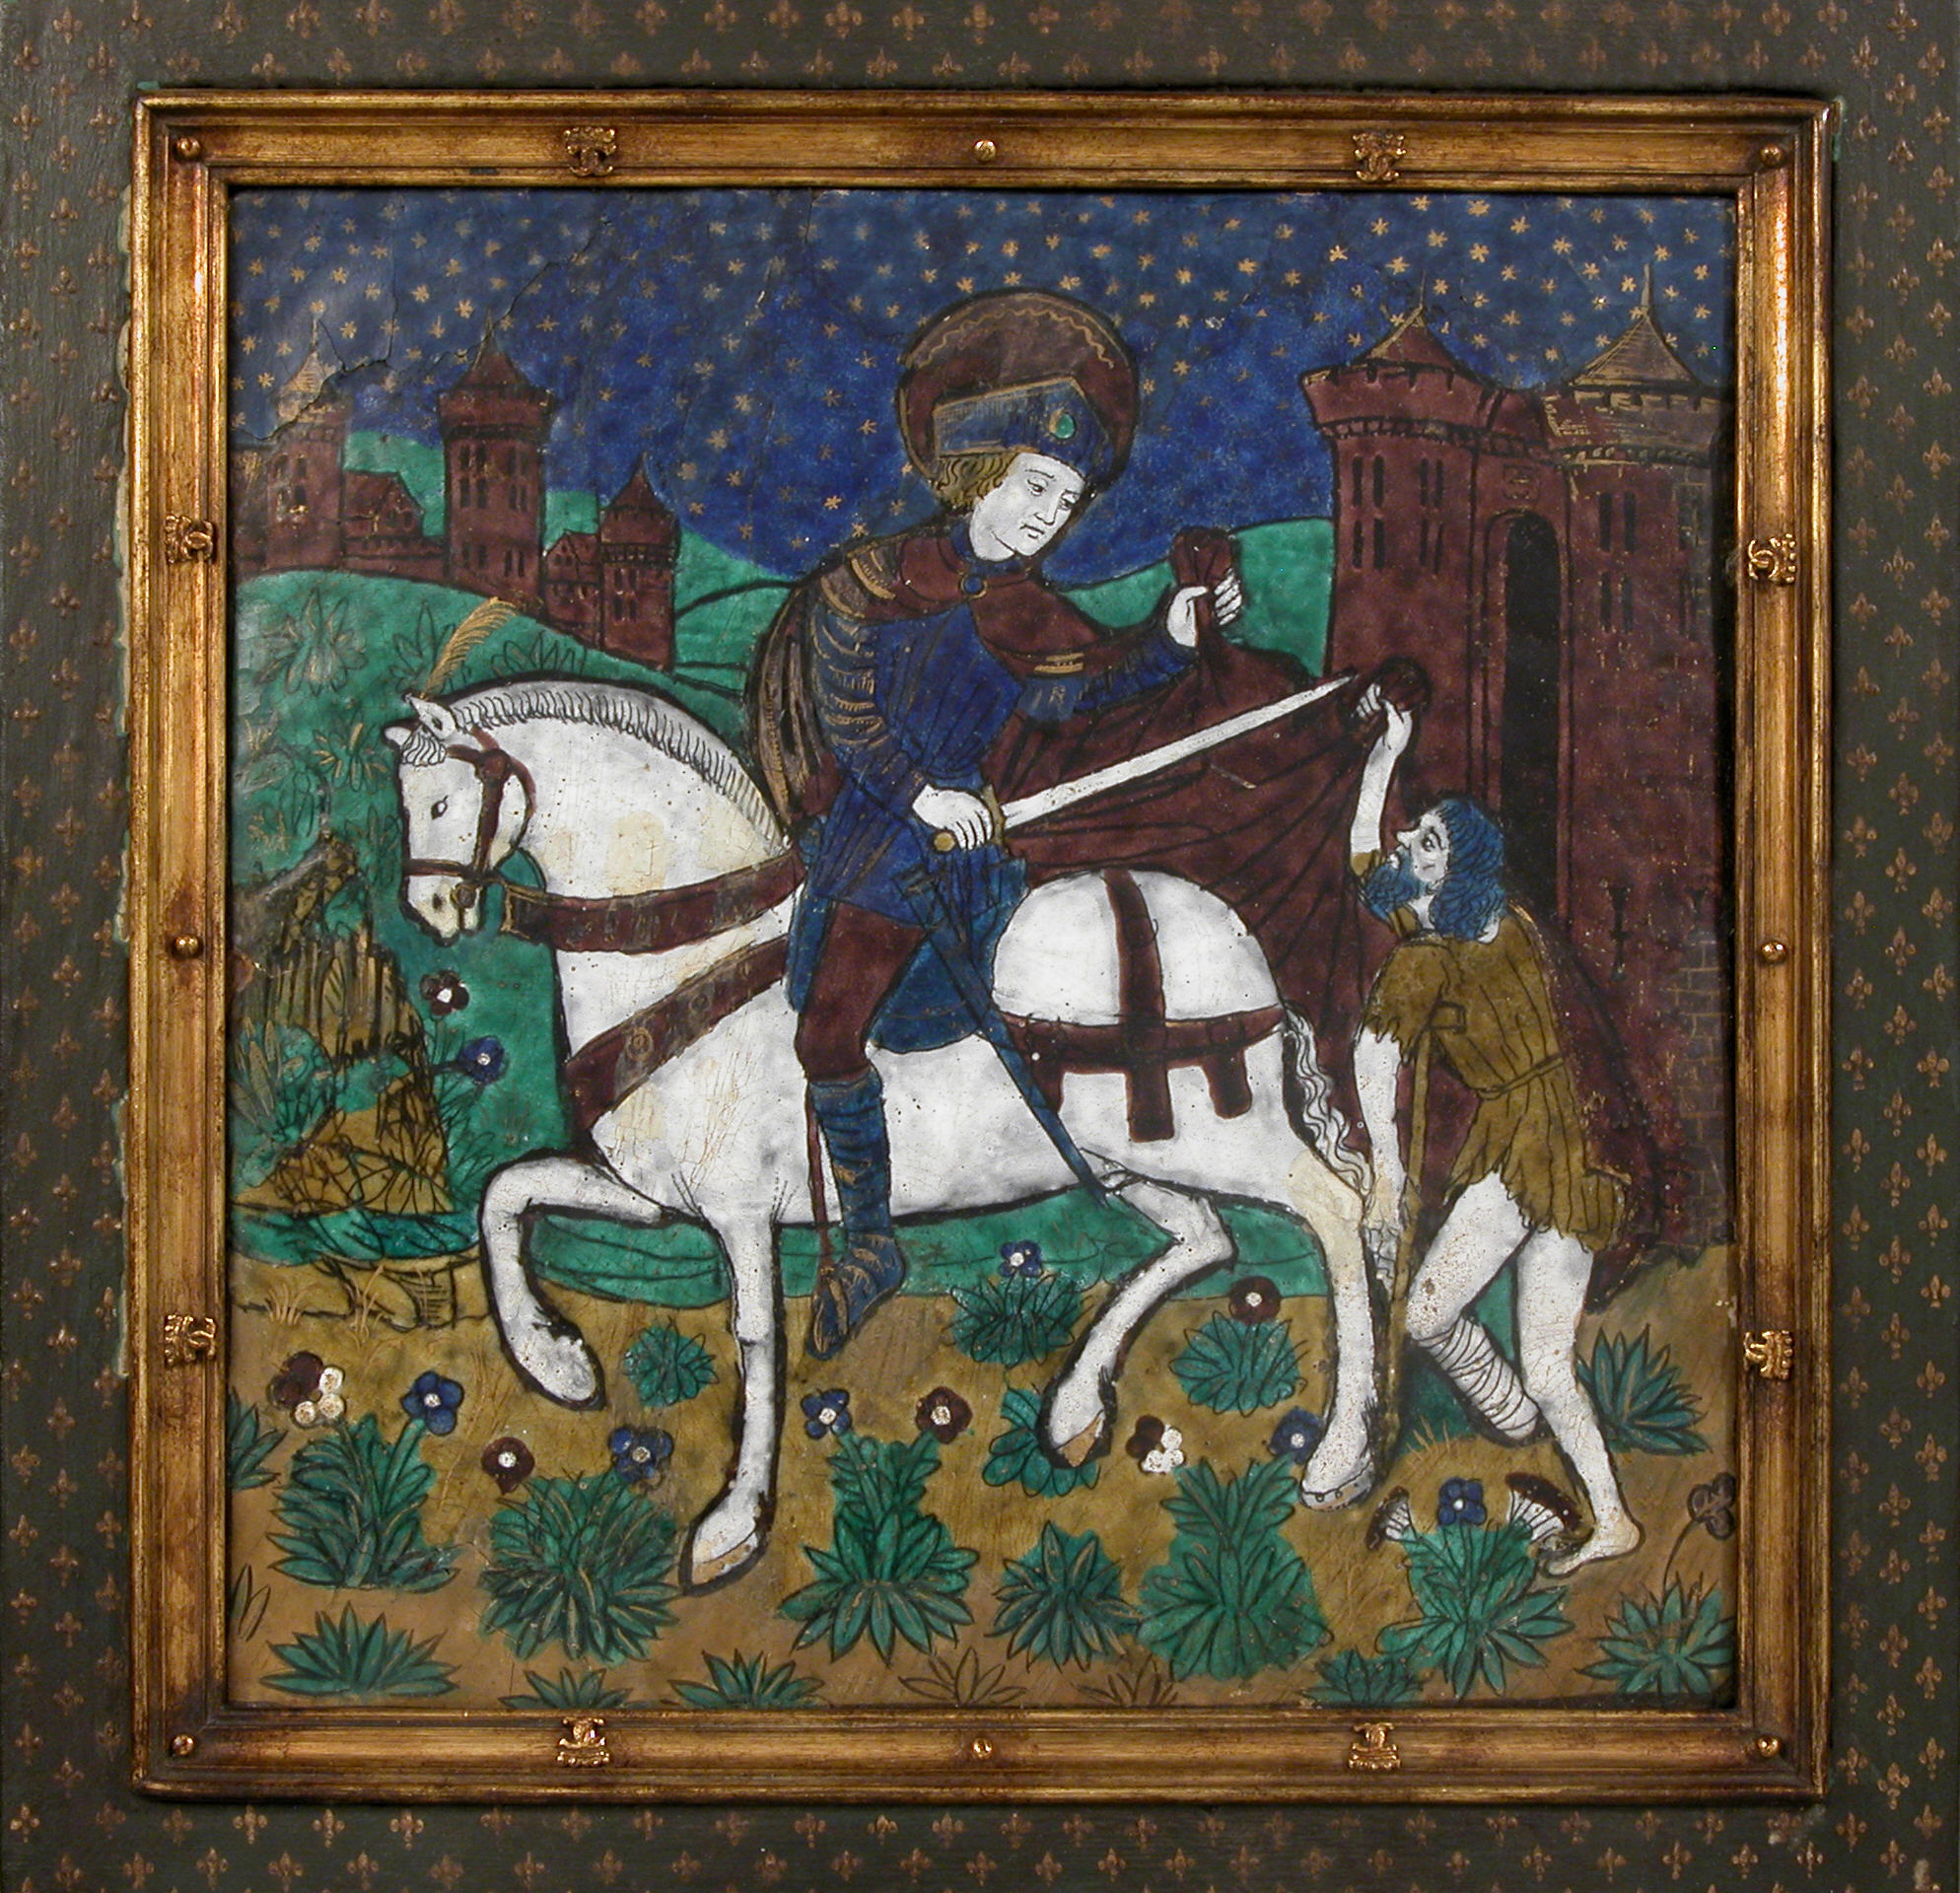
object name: plaque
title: Plaque with St. Martin and the Beggar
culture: french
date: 1501-1600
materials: copper, enamel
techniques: painting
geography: france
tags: swords,men,saints